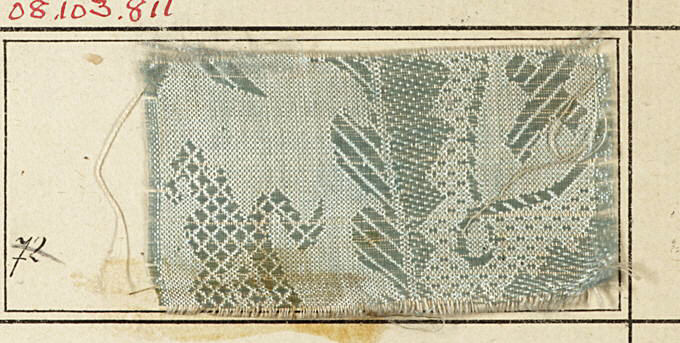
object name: ribbon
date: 1701-1900